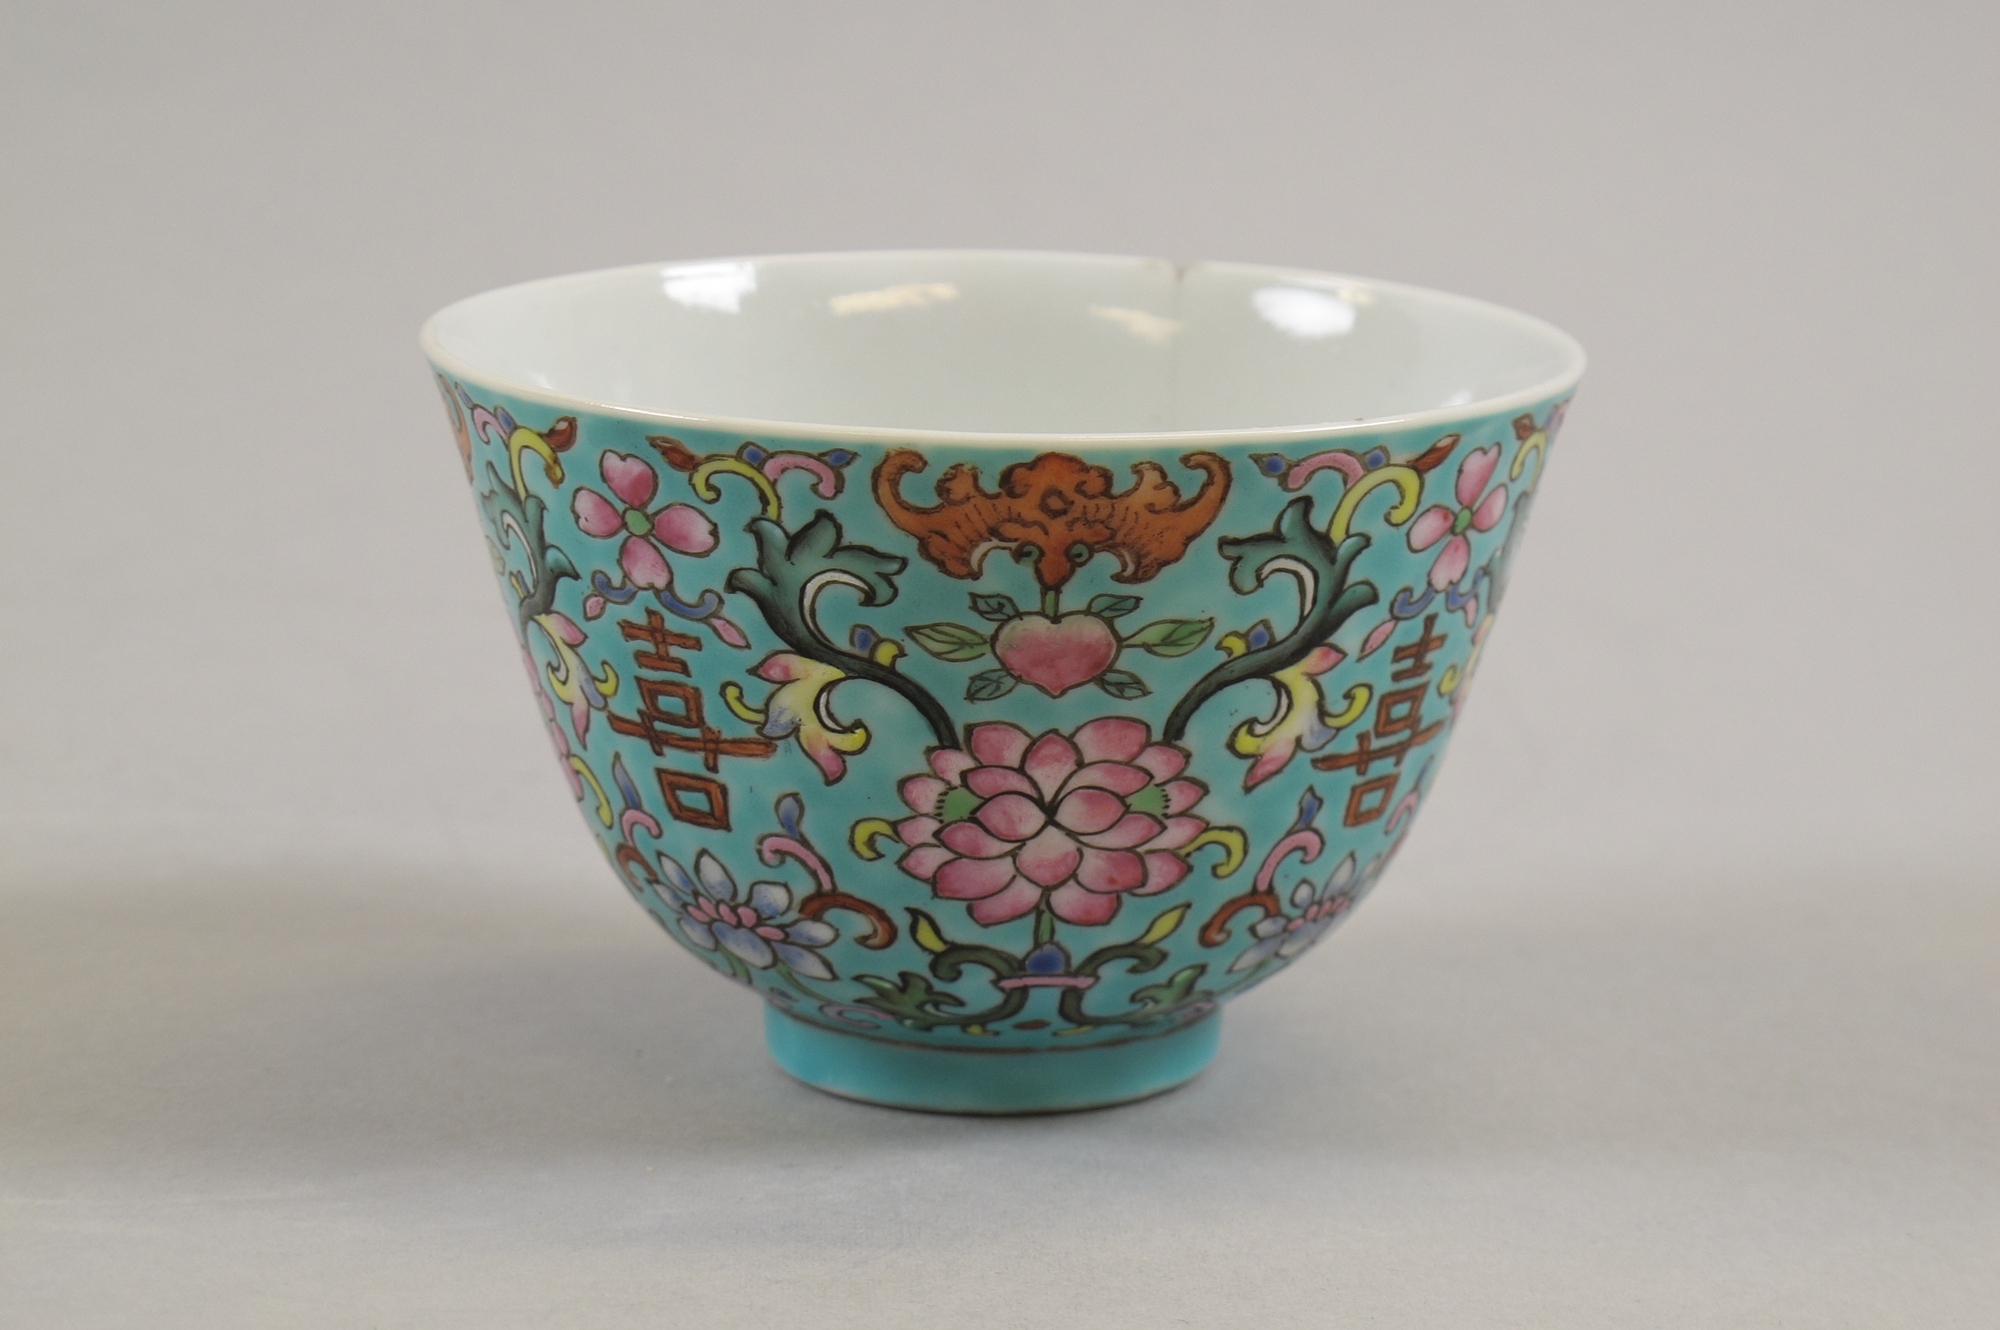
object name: cup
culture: chinese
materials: enamel, porcelain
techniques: overglaze, painting, polychrome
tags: flowers